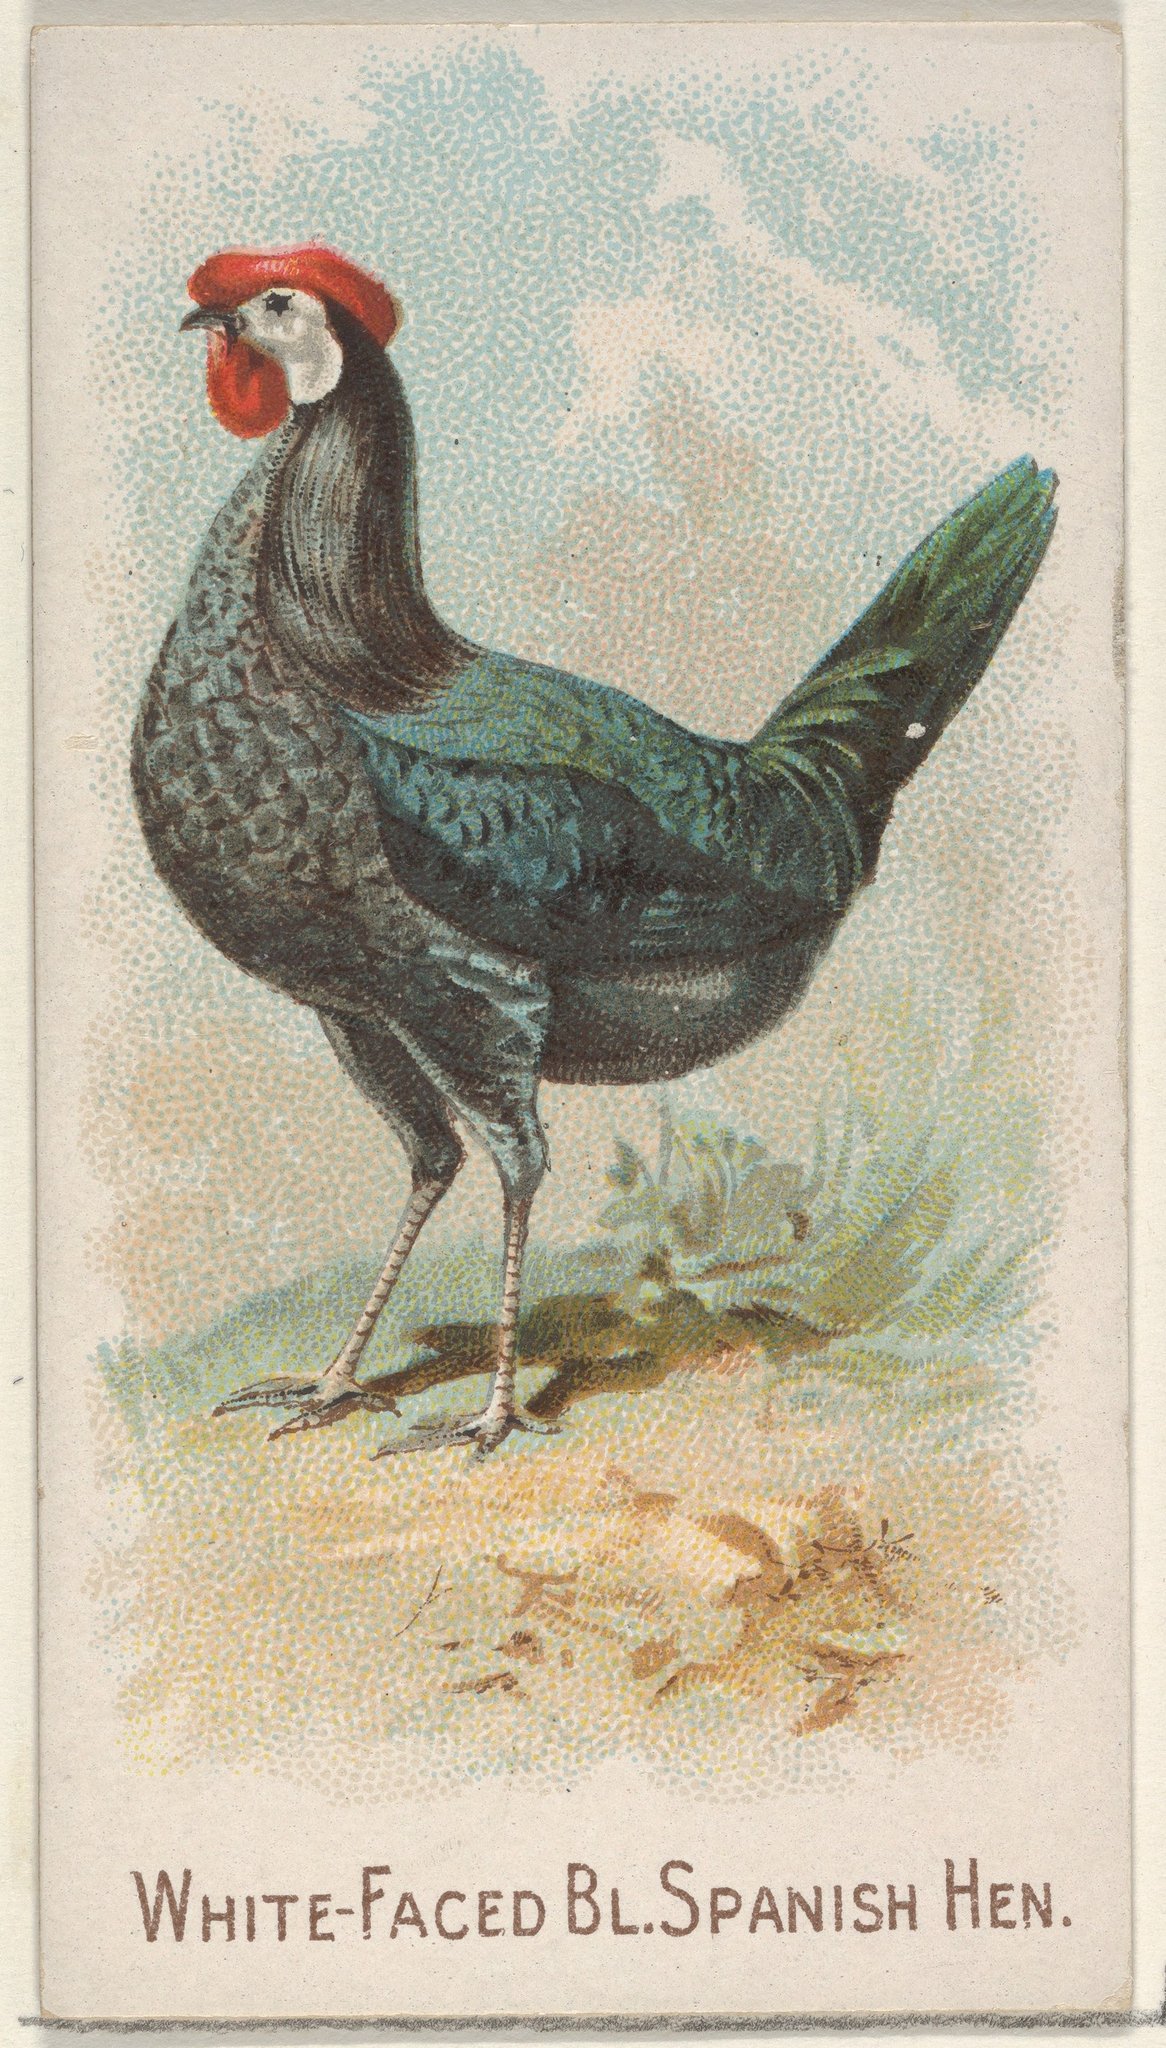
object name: print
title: White-Faced Black Spanish Hen, from the Prize and Game Chickens series (N20) for Allen & Ginter Cigarettes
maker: allen & ginter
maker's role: publisher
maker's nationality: american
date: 1891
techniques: color lithograph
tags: chickens